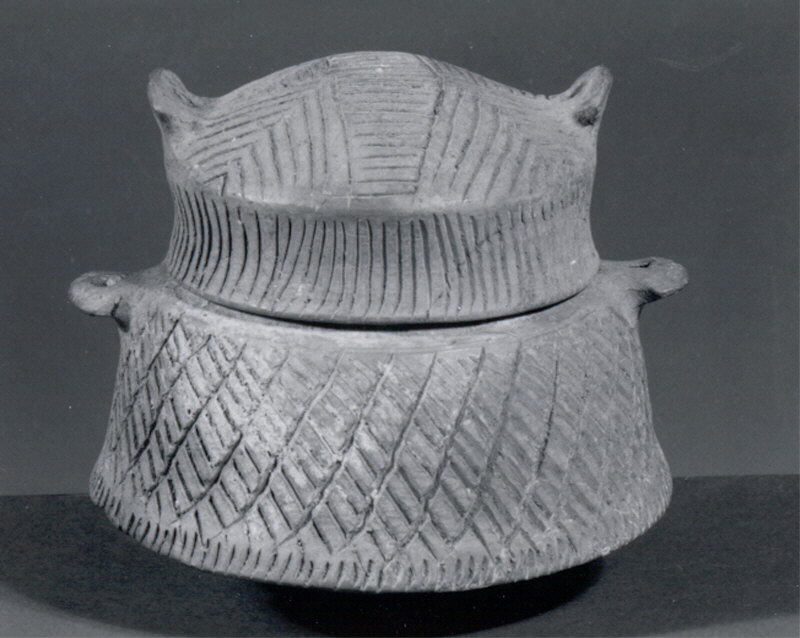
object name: vessel with lid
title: Vessel and lid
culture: iranian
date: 1000-1 BCE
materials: ceramic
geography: northwestern iran